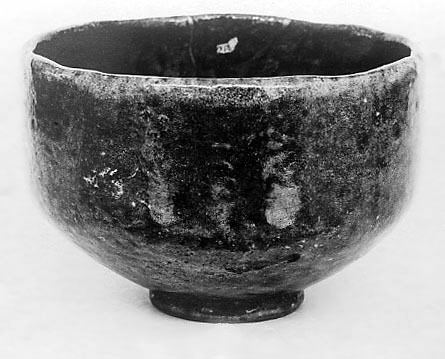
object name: bowl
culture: japanese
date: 1701-1800